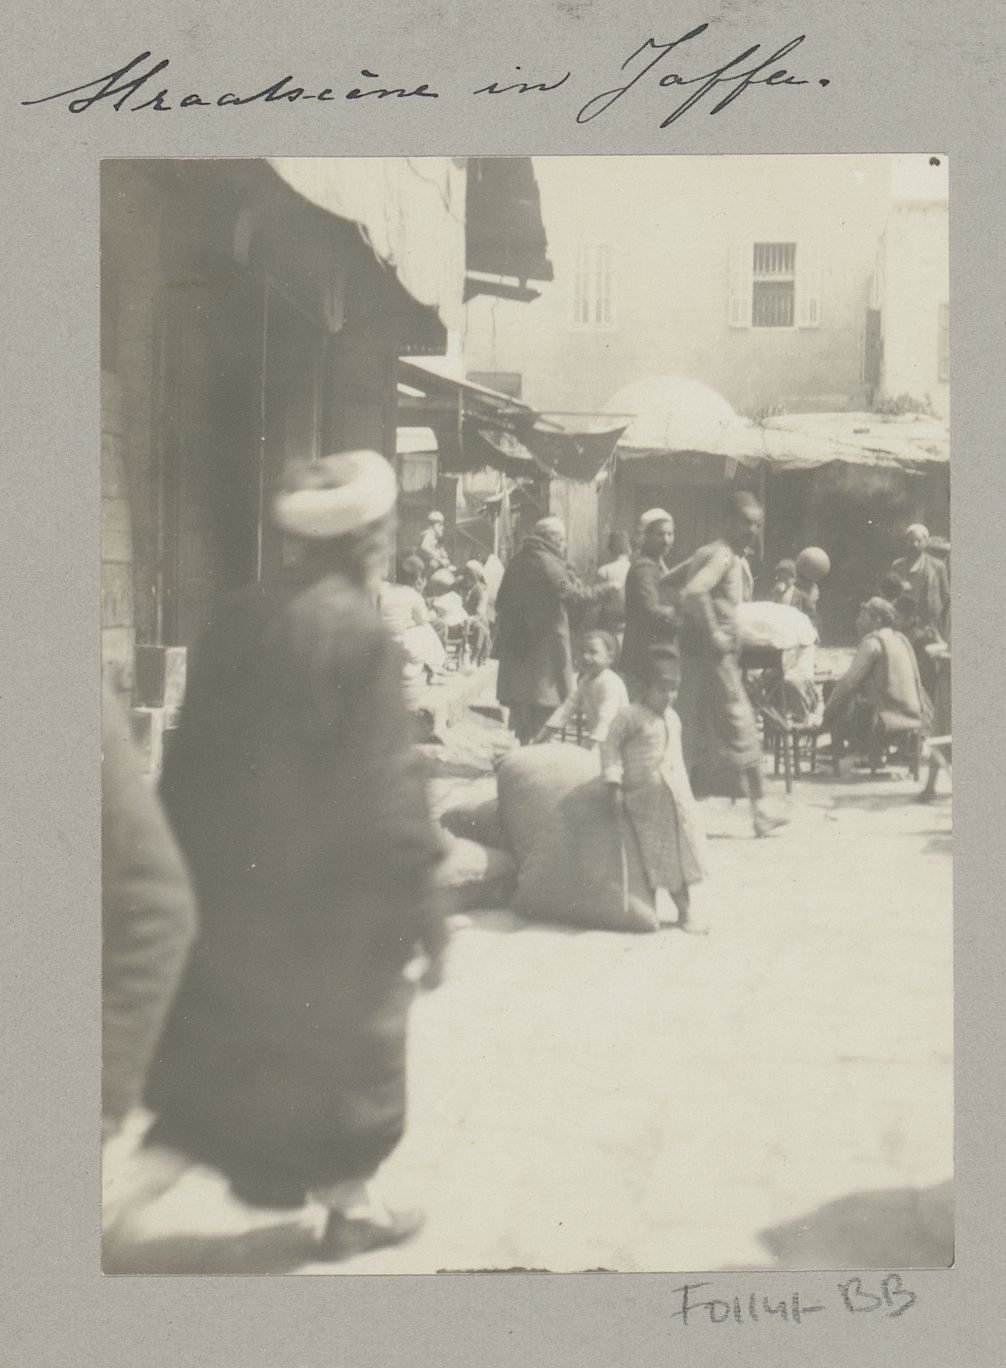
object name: photograph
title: Straatgezicht in Jaffa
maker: Anonymous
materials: photographic support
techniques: gelatin silver print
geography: jaffa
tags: street (+ city(-scape) with figures, staffage)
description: Onderdeel van Fotoalbum van een reis door Zuid-Europa en het Midden-Oosten.